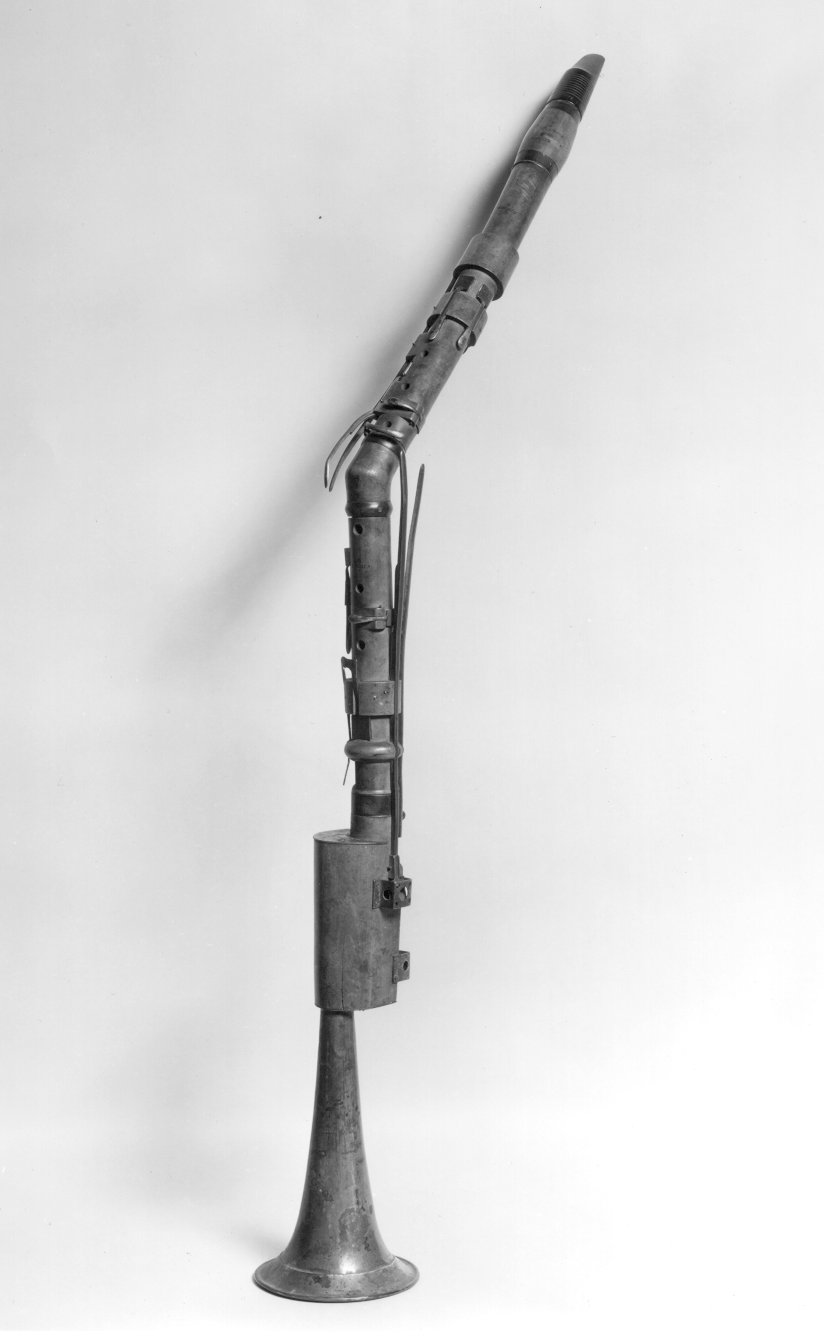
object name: basset horn in f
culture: czech or hungarian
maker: anton fischer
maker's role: maker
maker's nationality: hungarian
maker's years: 1885-1895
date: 1834-1866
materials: brass, horn, wood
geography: bohemia